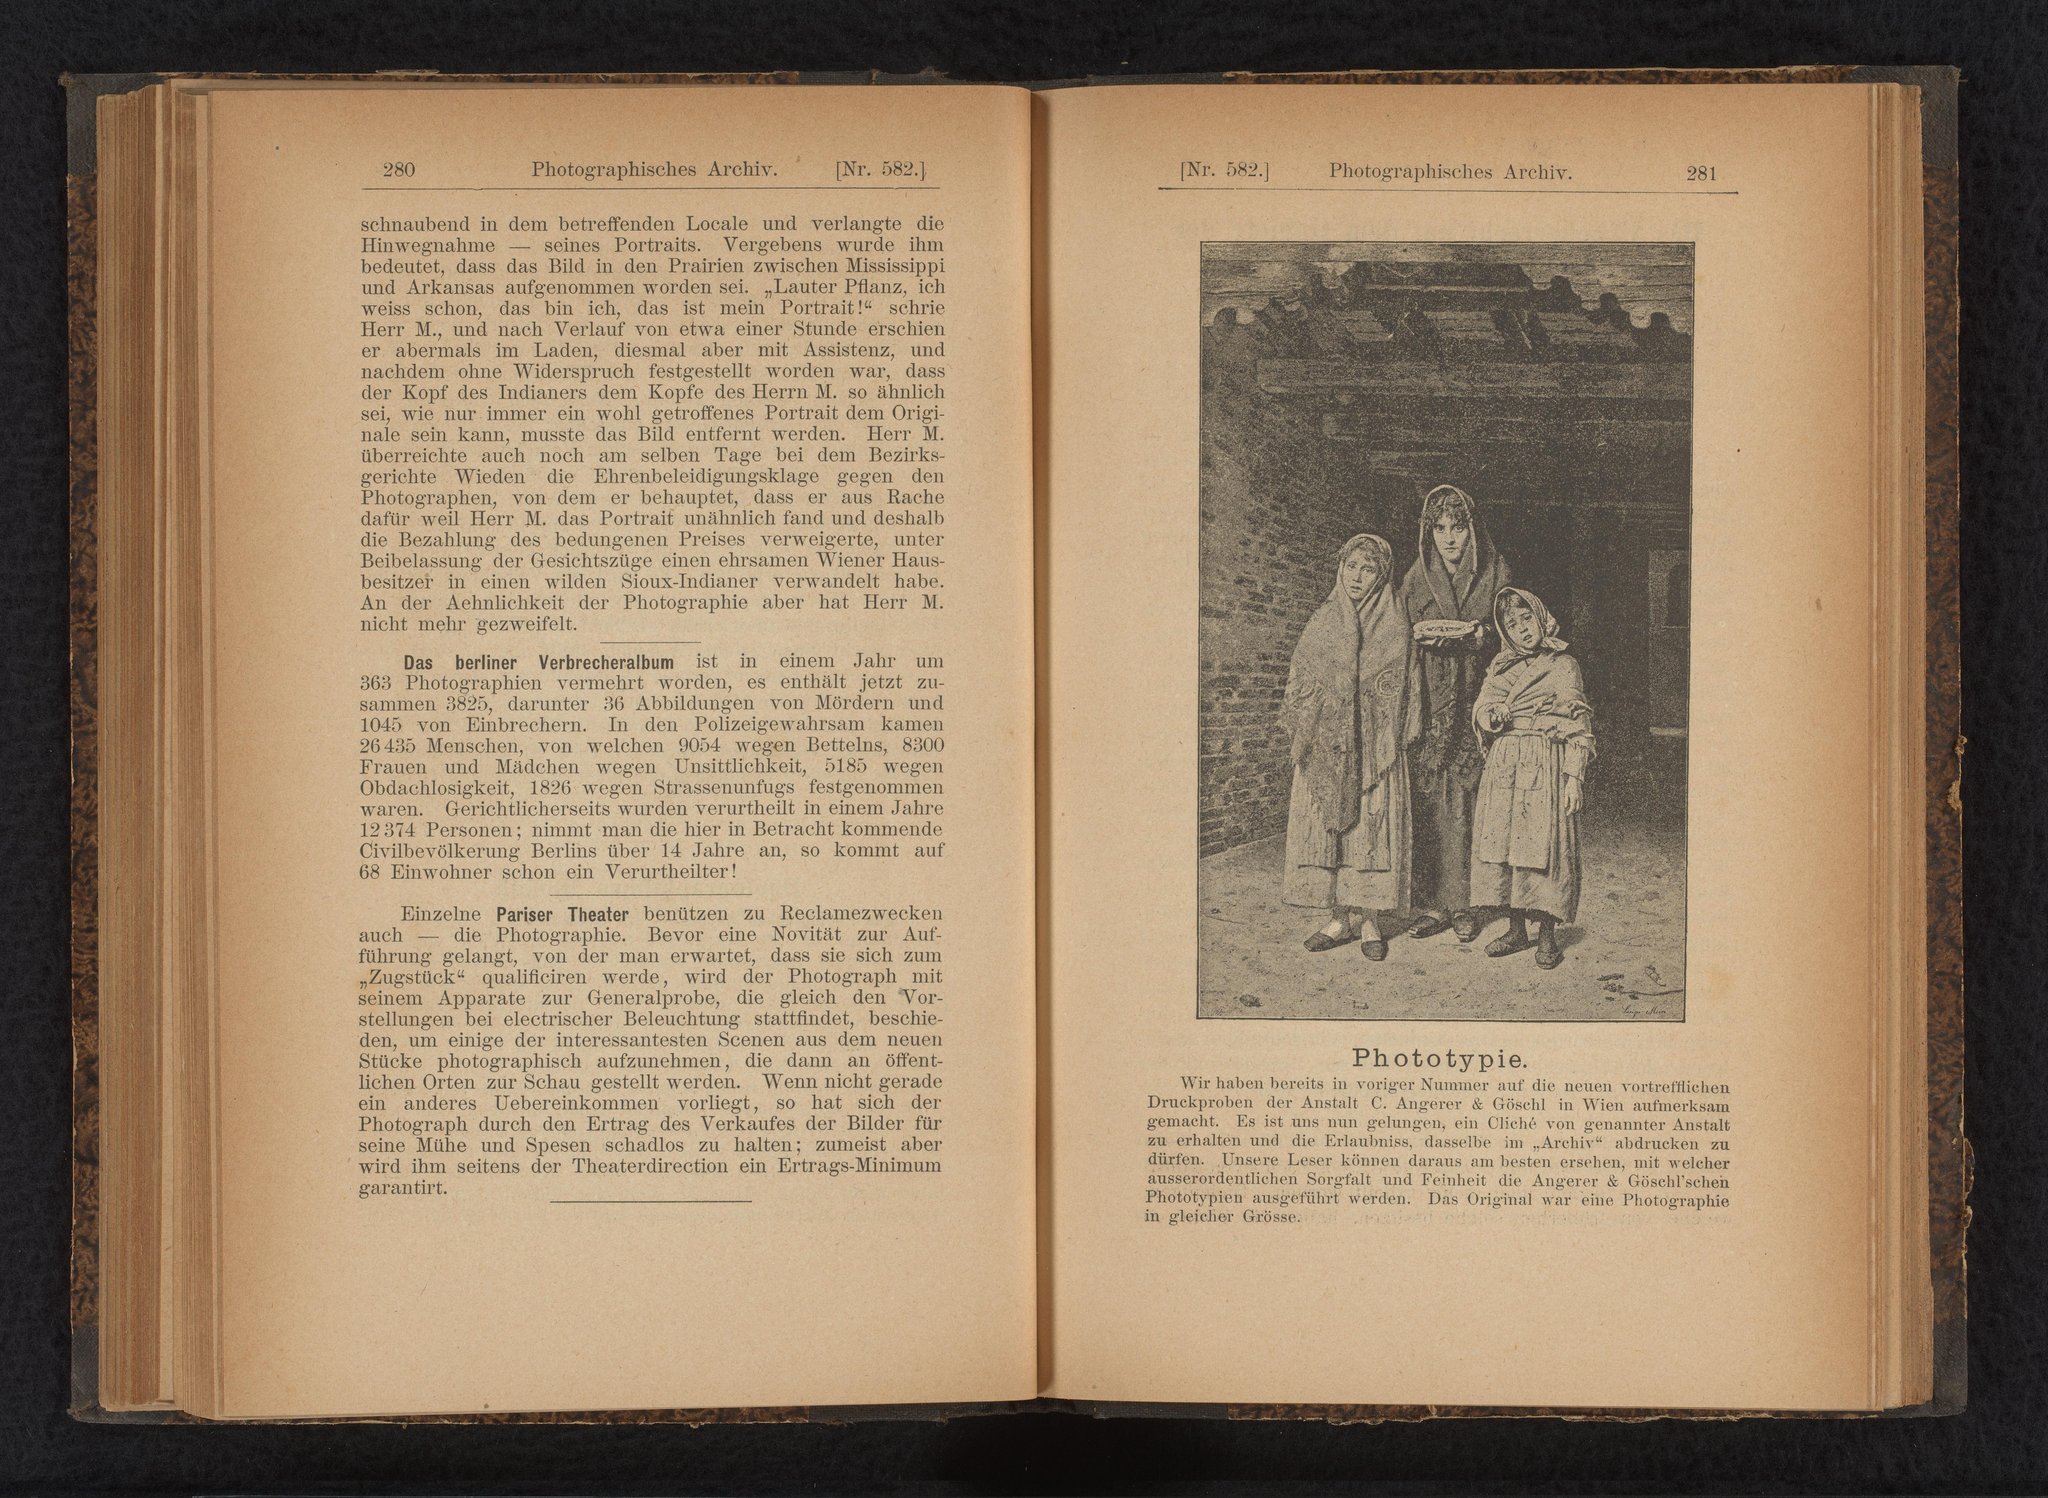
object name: photomechanical print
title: Groepsportret van drie onbekende bedelaars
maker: Anonymous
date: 1882-1887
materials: paper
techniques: autotype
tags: beggar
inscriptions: inscription: ‘Phototypie./ Wir haben (...) gleicher Grösse.’